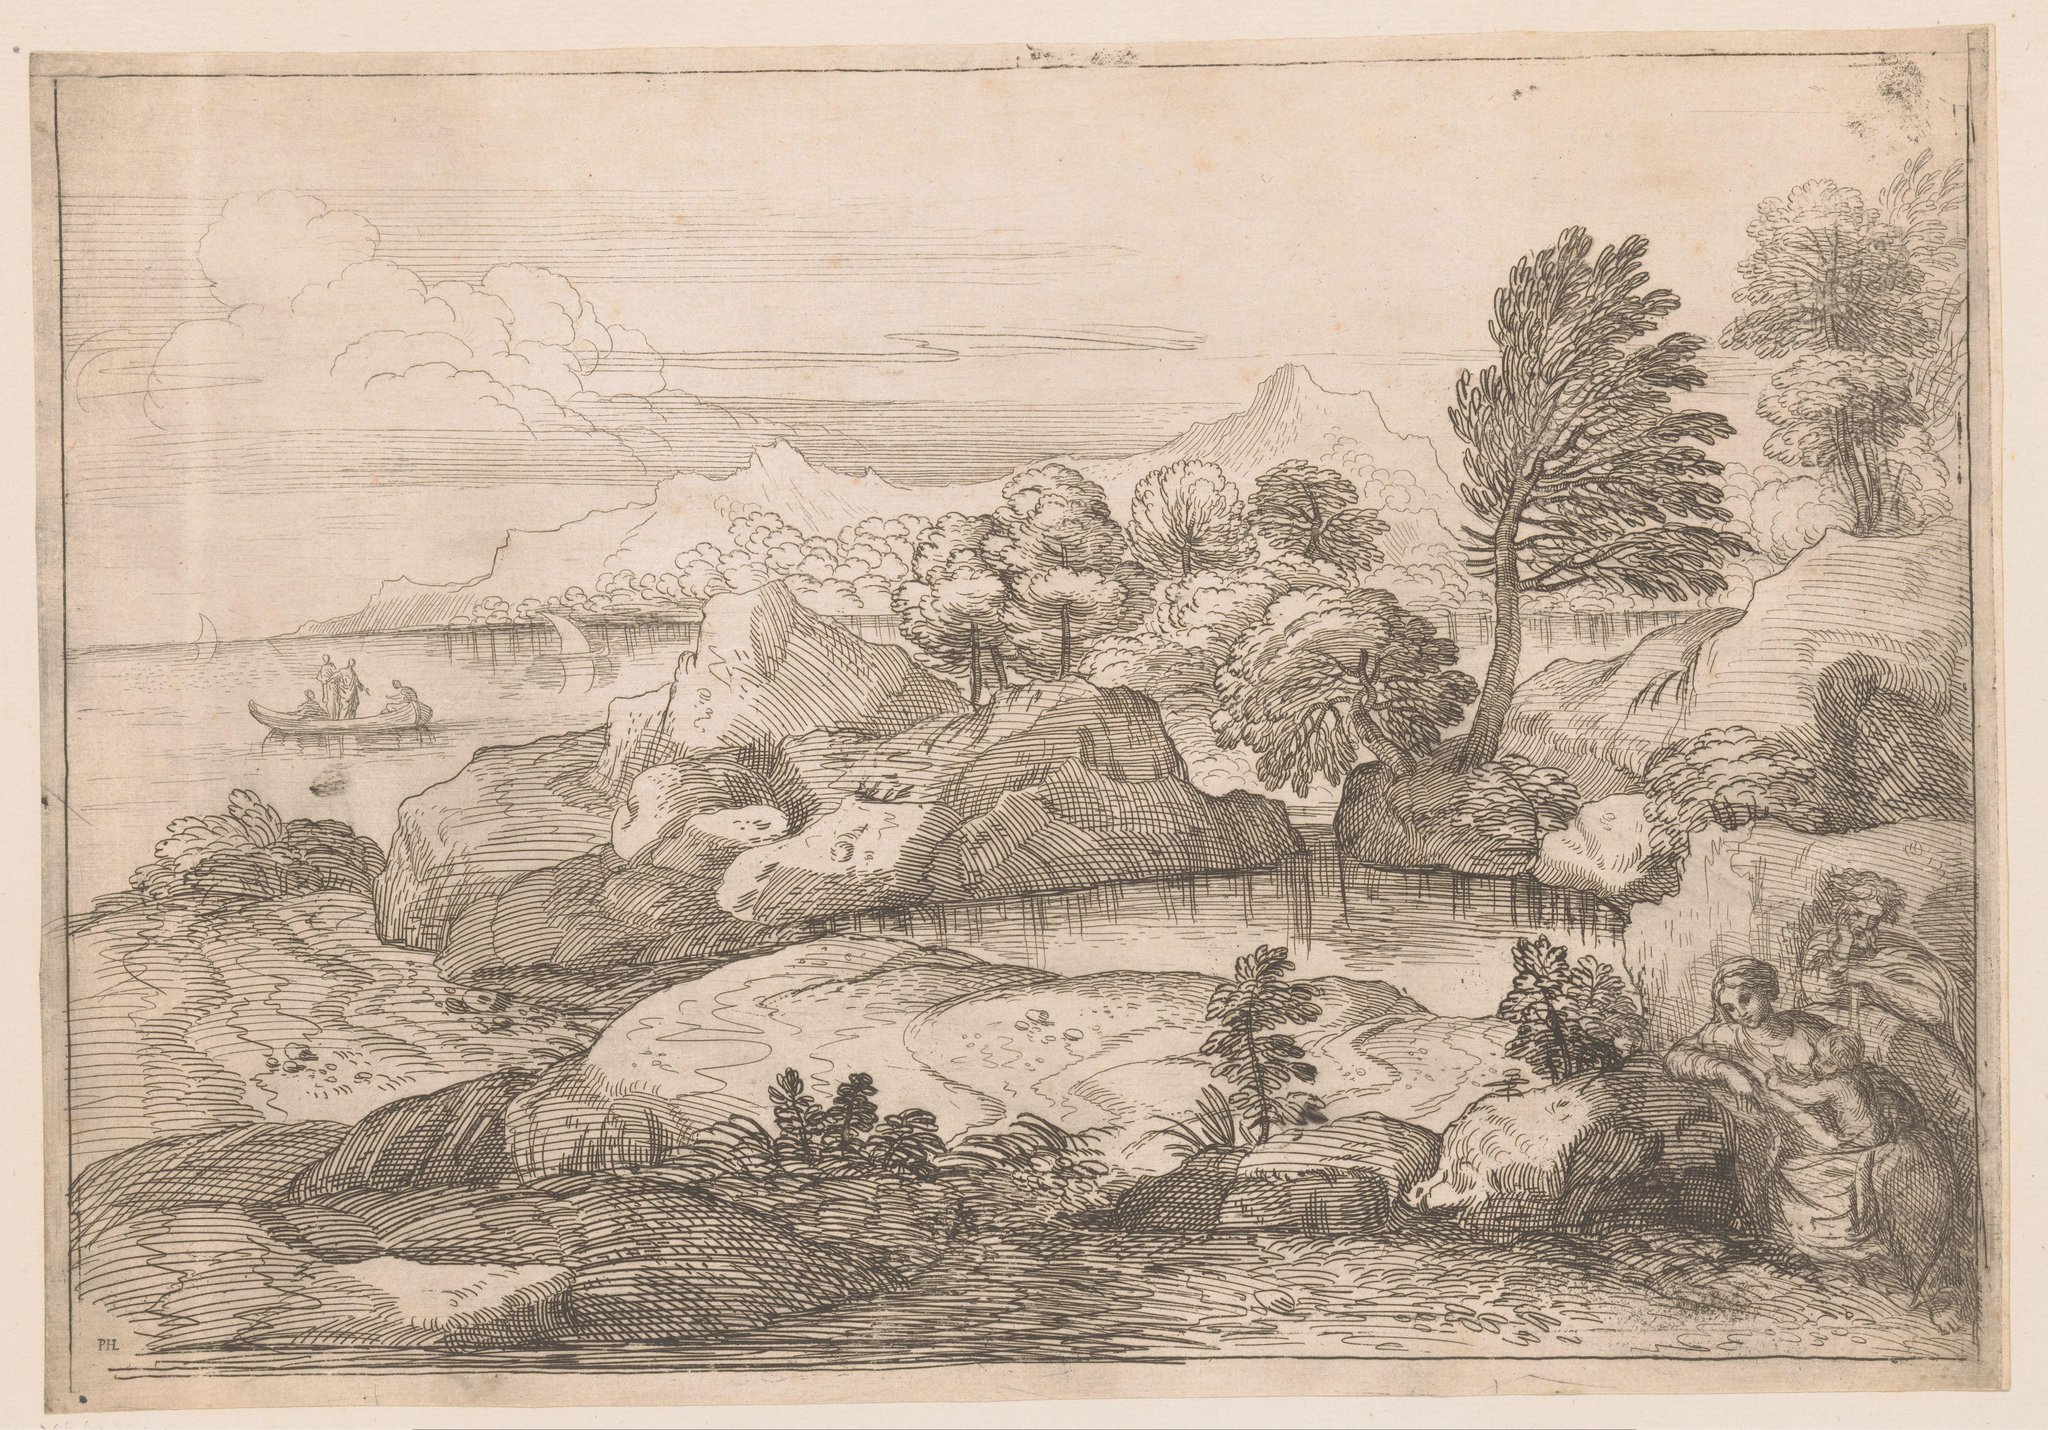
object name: print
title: Landschap met Heilige Familie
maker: charles macé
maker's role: draughtsman, print maker, sculptor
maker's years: 1631-1665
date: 1641-1731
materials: paper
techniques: etching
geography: france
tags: holy family, and derived representations, landscapes with waters, waterscapes, seascapes (in the temperate zone)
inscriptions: collector's mark: Lugt 2090, collector's mark: Lugt 240